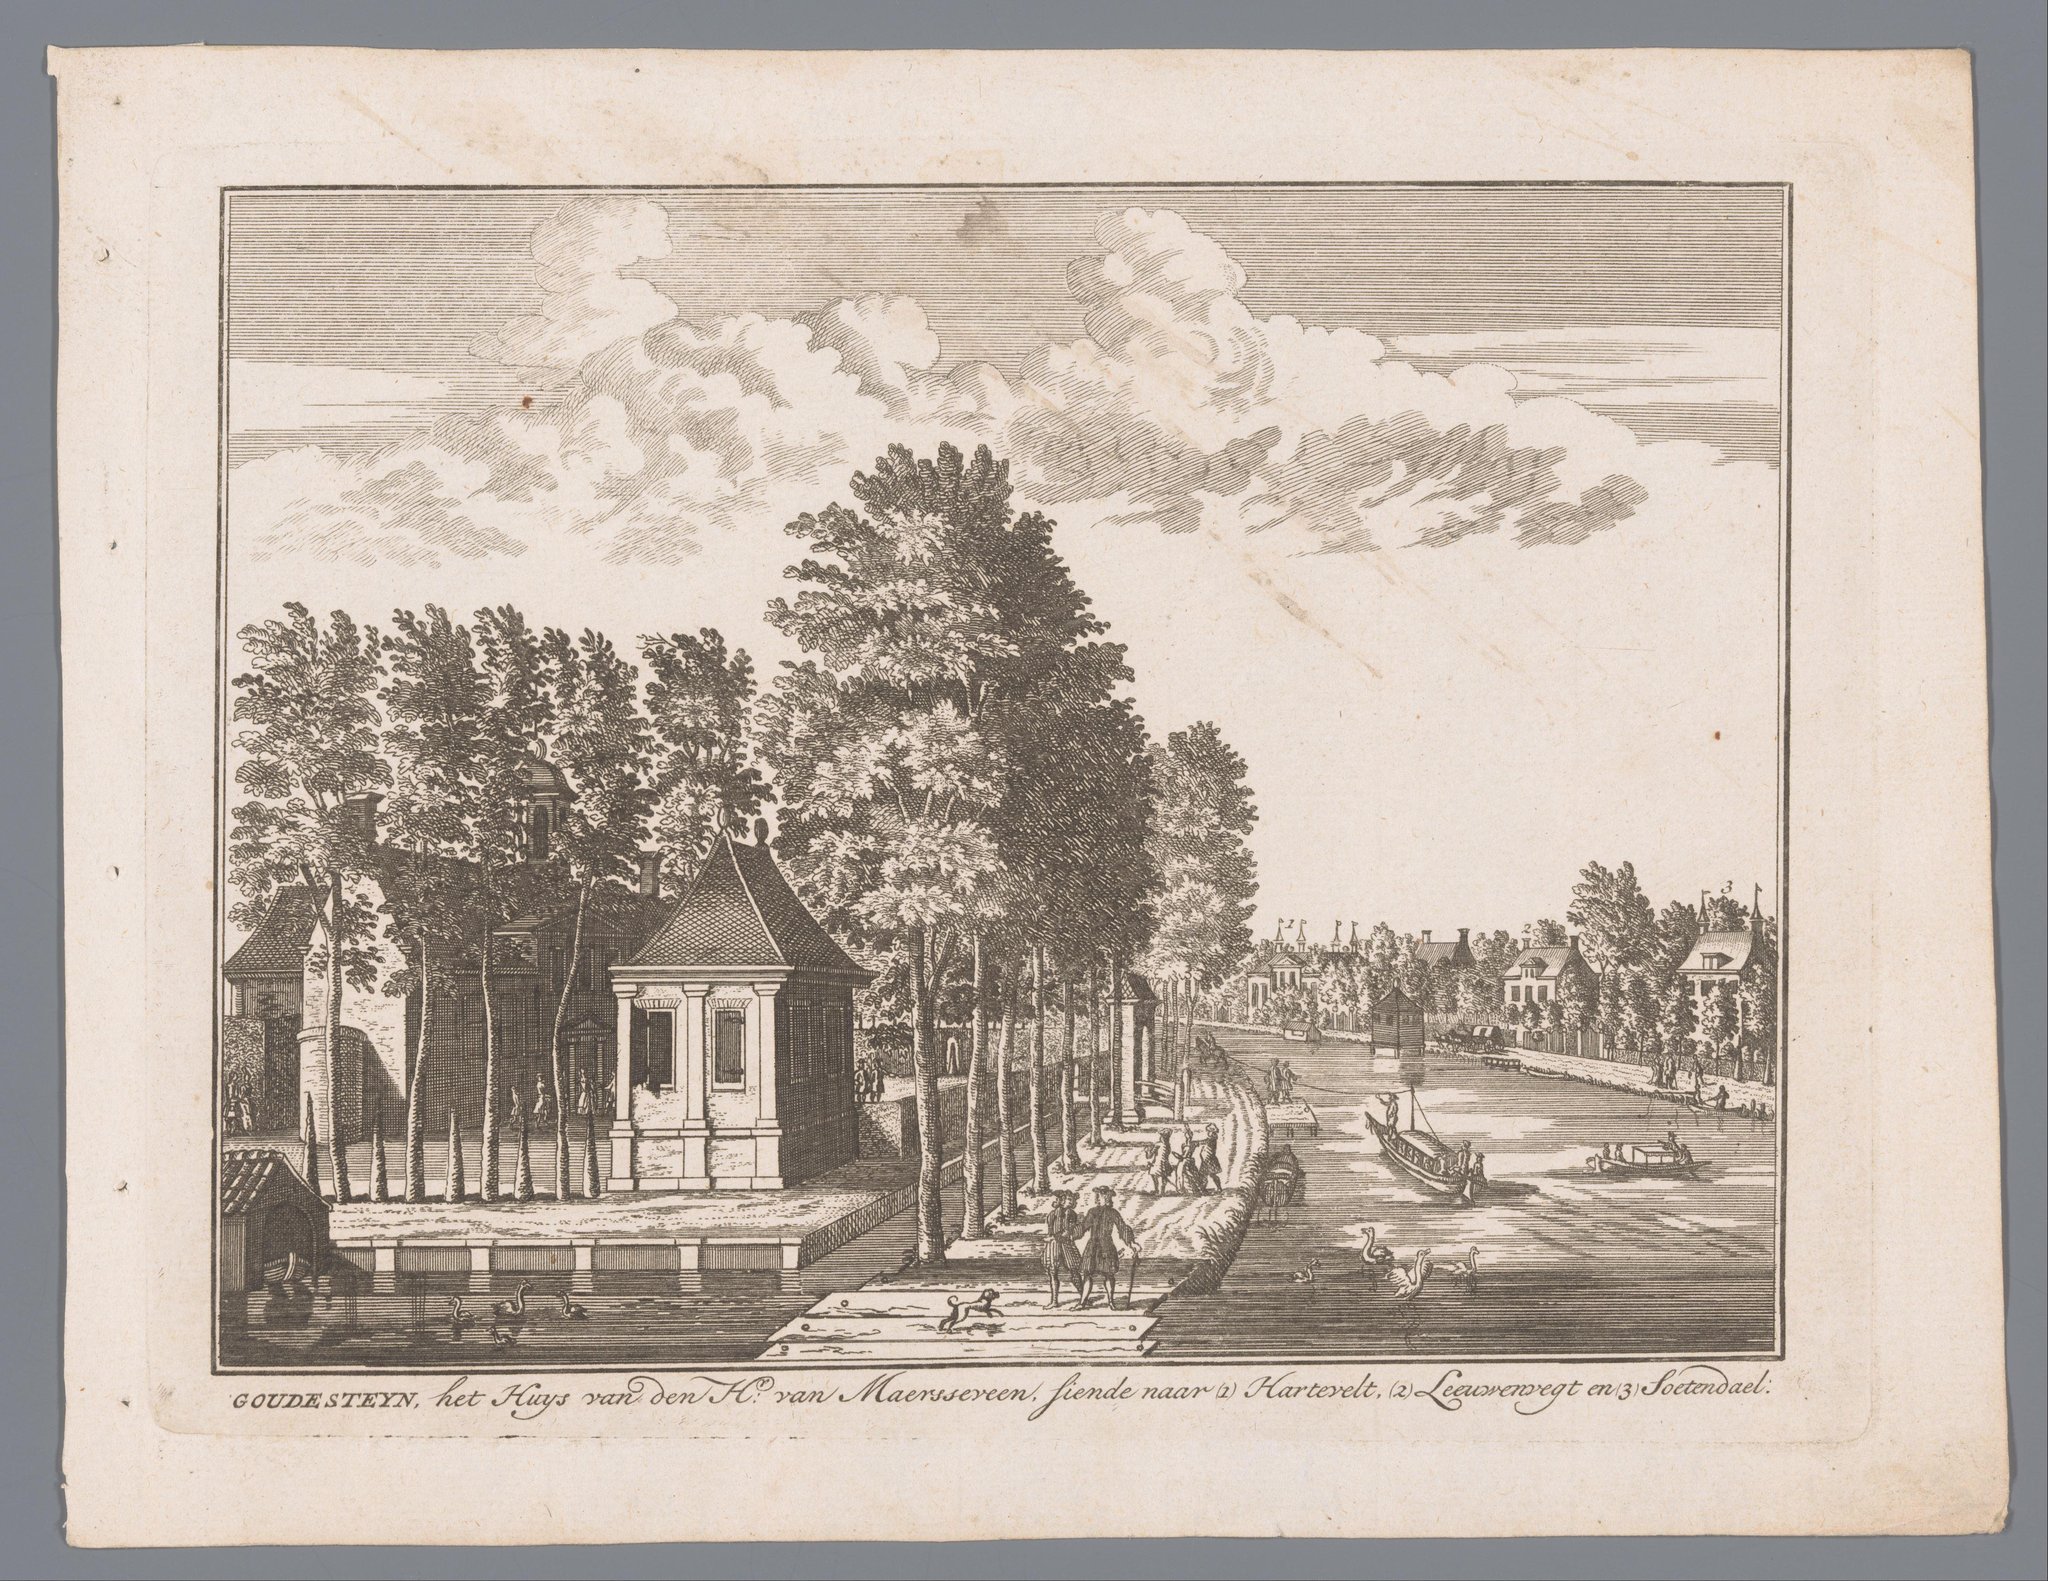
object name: print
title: Goudestein, het huys van den Hr. van Maersseveen, siende naar (1) Hartevelt, (2) Leeuwenvegt en (3) Soetendael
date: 1718-1757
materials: paper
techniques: etching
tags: rural housing, e.g. country-house, villa, cottage, maarssen, vecht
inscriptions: collector's mark: Lugt 2228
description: Behoort tot een reeks van elf stuks met verschillende buitenplaatsen. Naar prent in: Stopendaal, Daniel. De zegepraalende Vecht, vertoonende verscheidenen gesichten van lustplaatsen, heeren huysen en dorpen, beginnende van Uitrecht en met Muyden besluytende. Amsterdam: Weduwe Nicolaas Visscher, 1719.